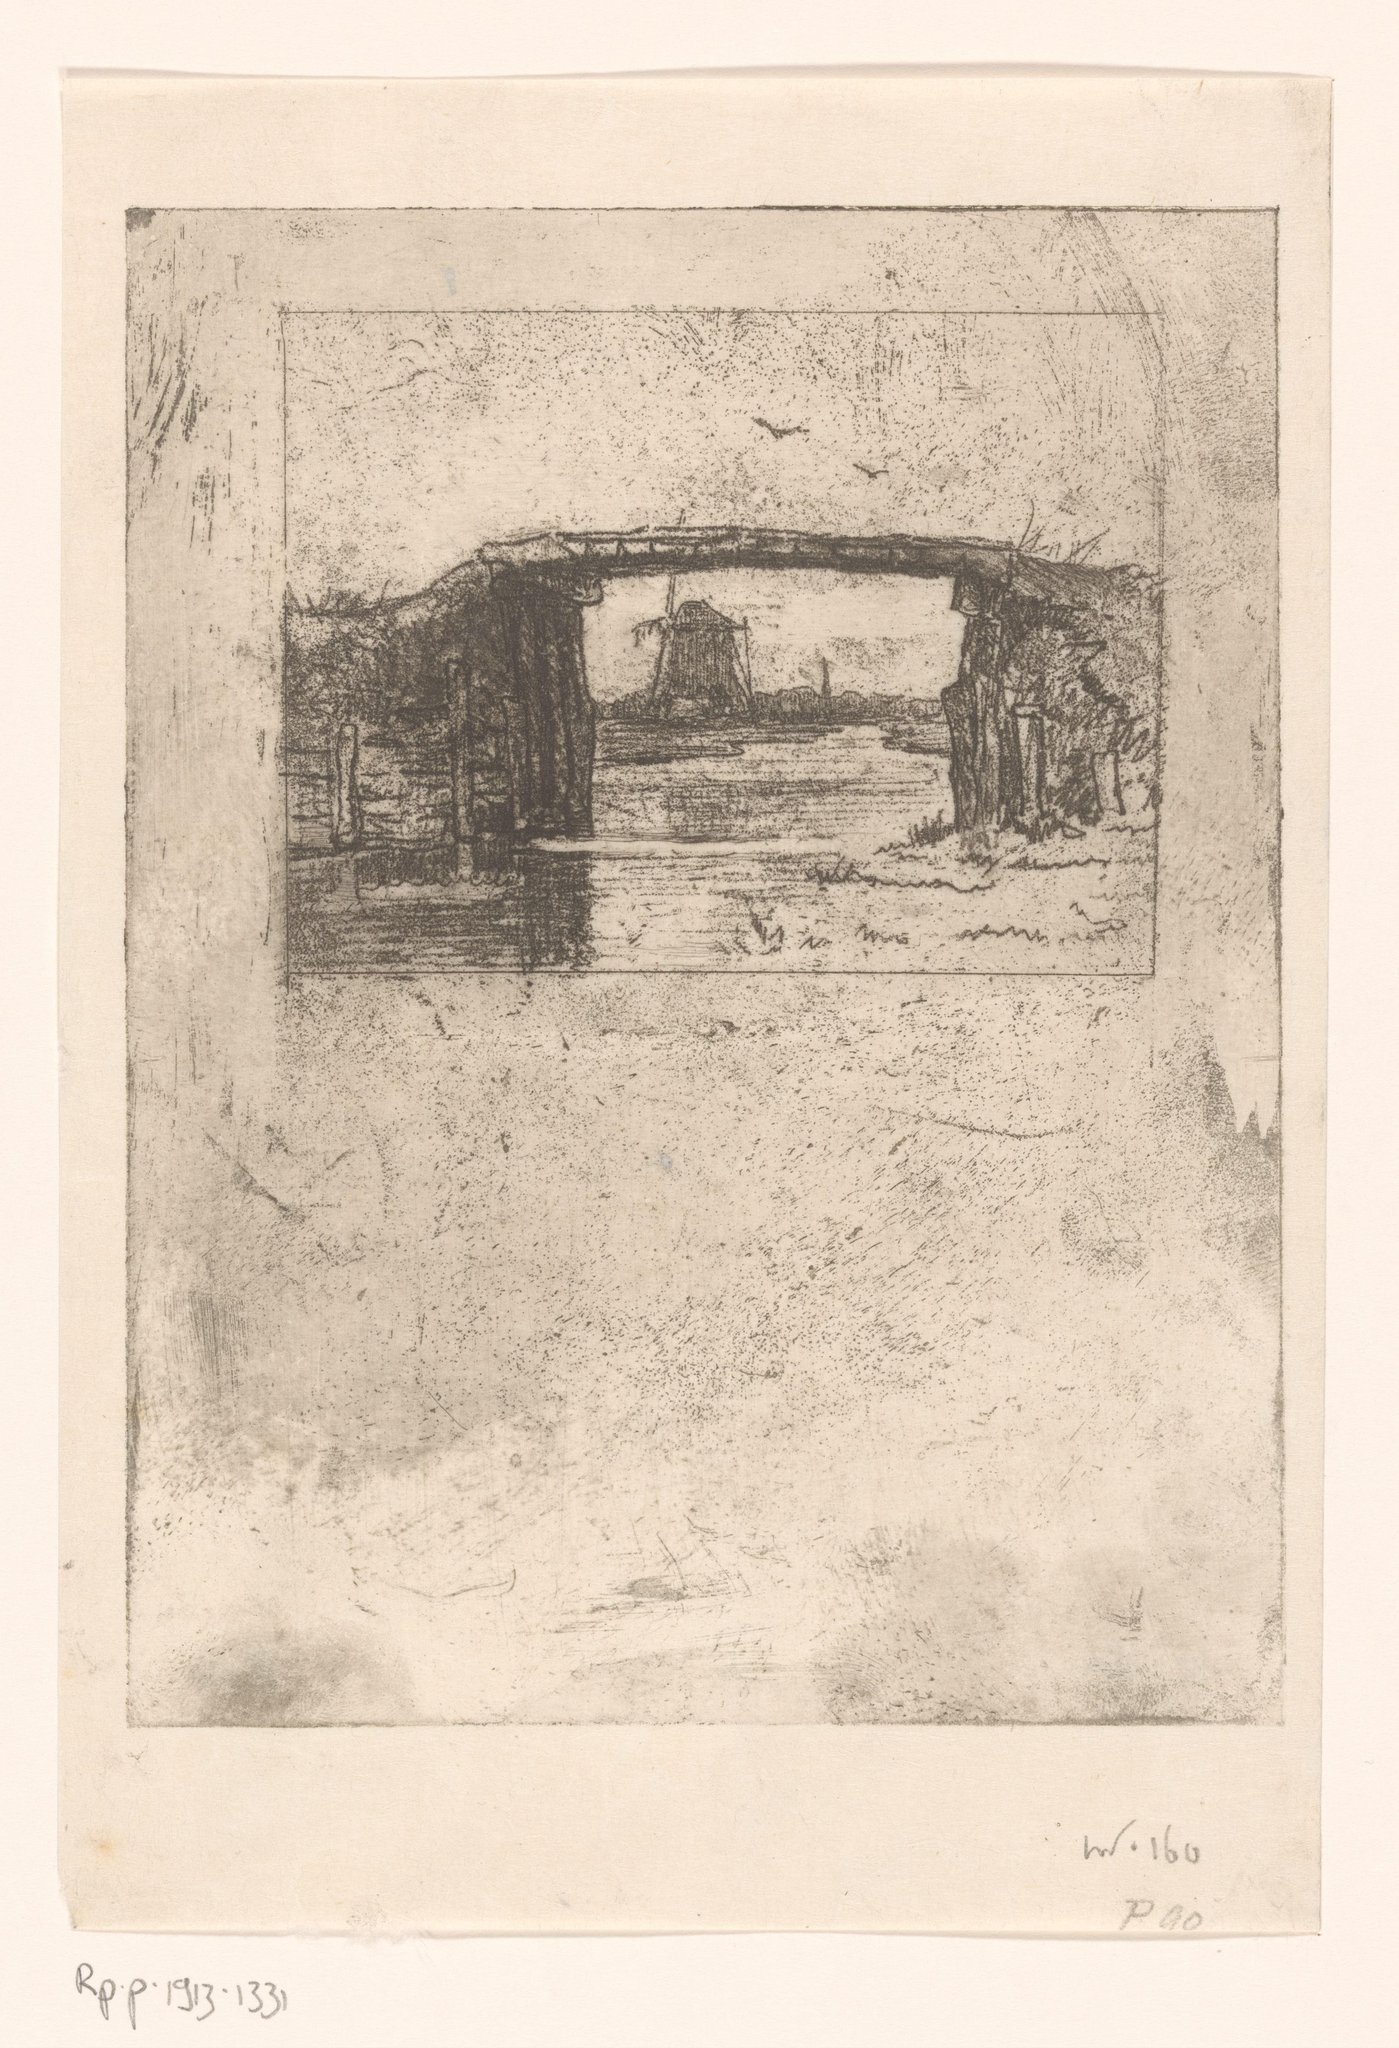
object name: print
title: Gezicht op een molen onder een brug door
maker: philip zilcken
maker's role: draughtsman, painter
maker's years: 1857-1930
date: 1867-1890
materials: paper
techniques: drypoint, intaglio, soft ground etching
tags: windmill in landscape, bridge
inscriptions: collector's mark: Lugt 2233